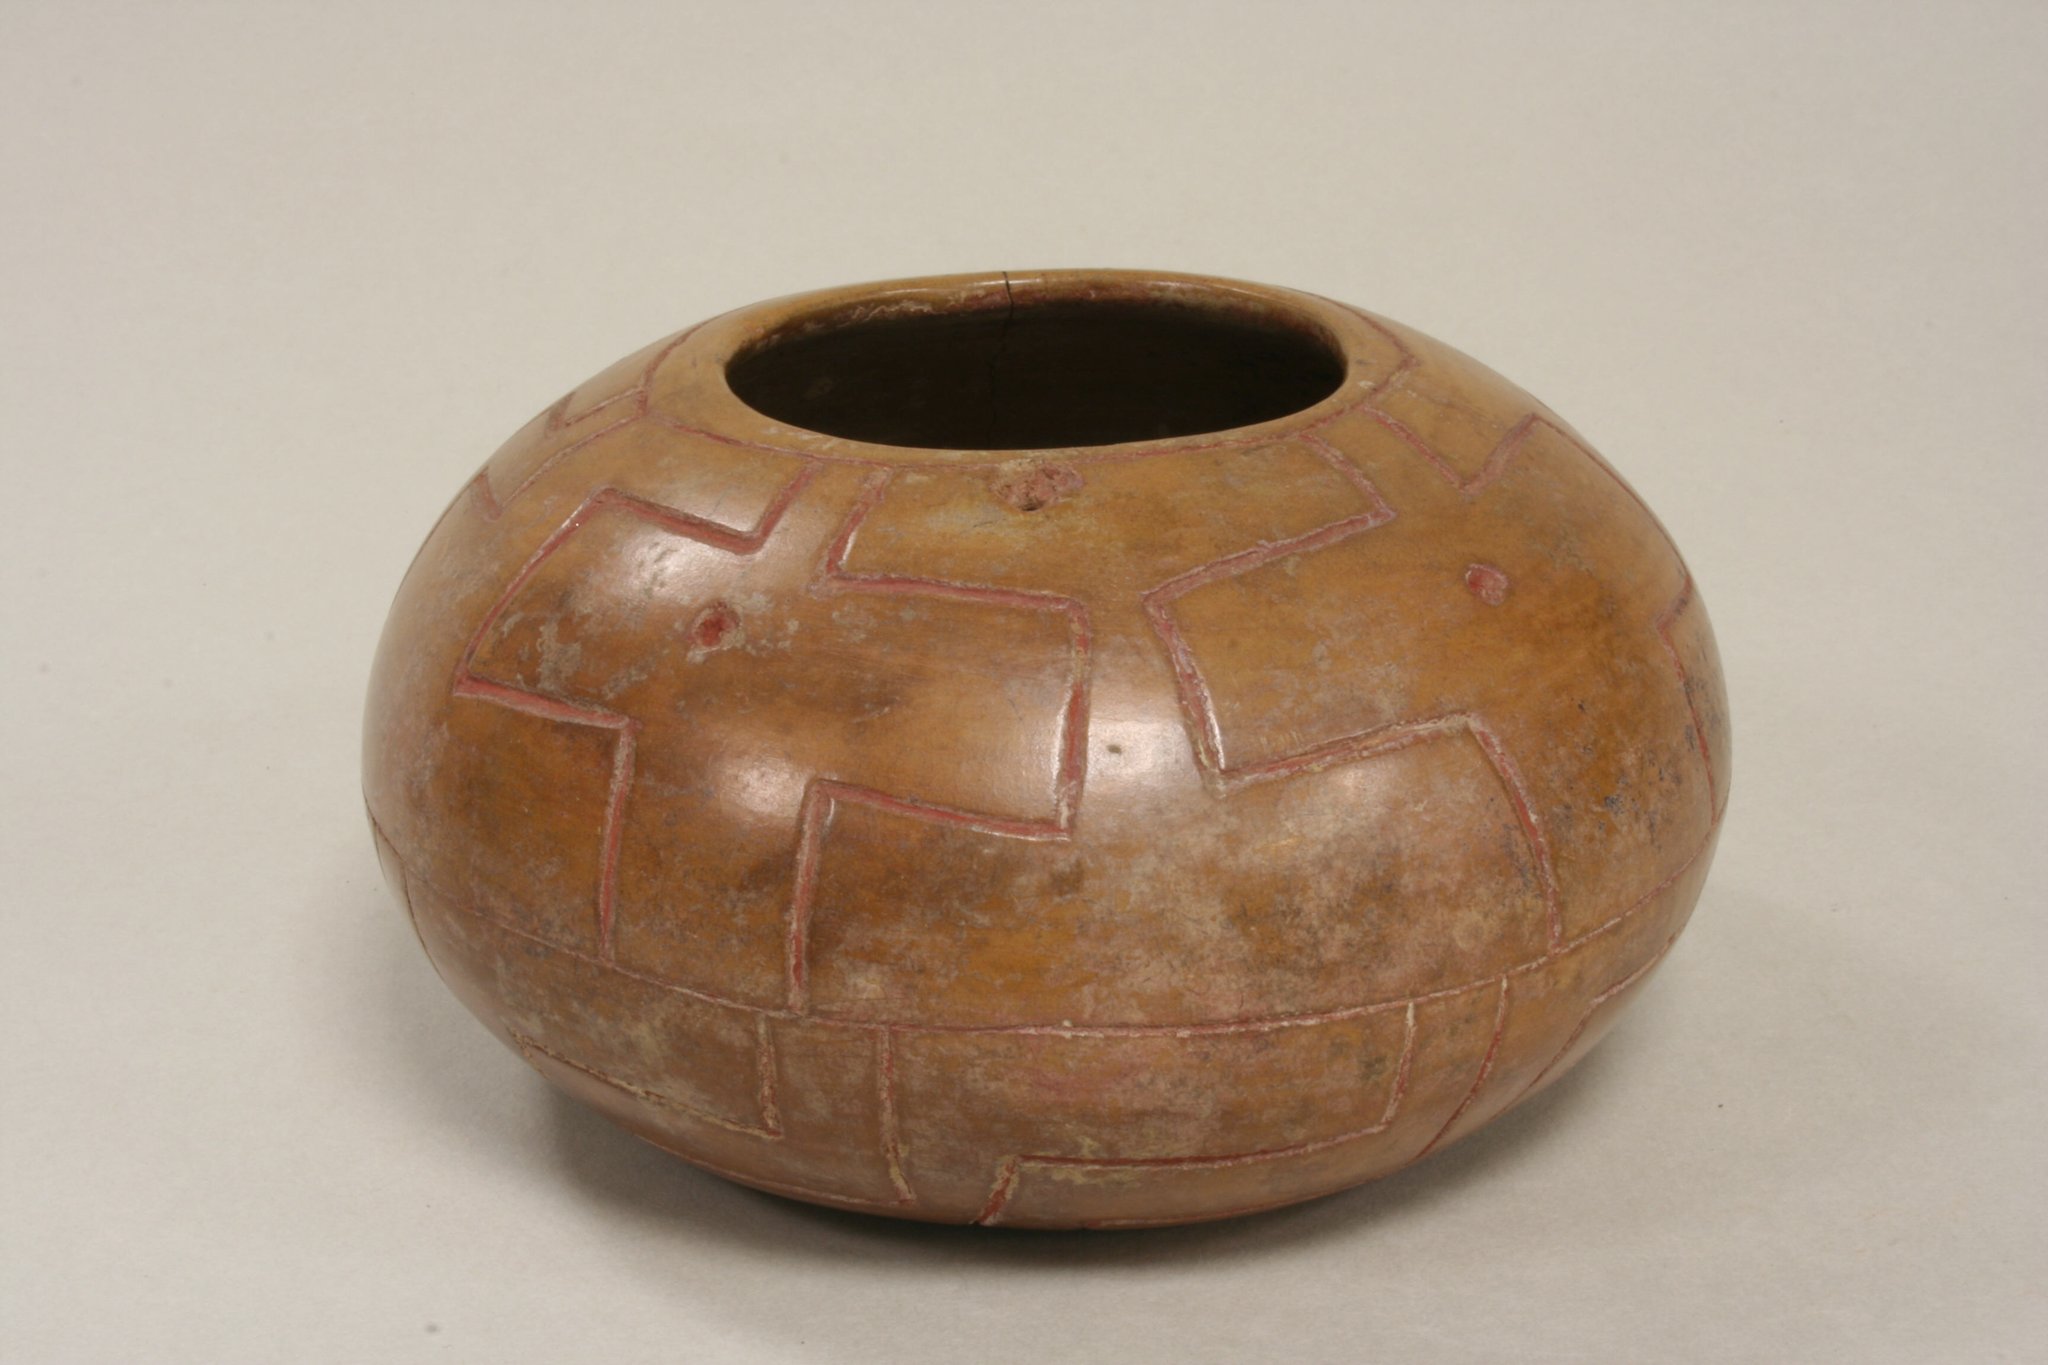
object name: bowl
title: Incised Bowl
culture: mexican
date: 1501-1600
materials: ceramic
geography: mexico